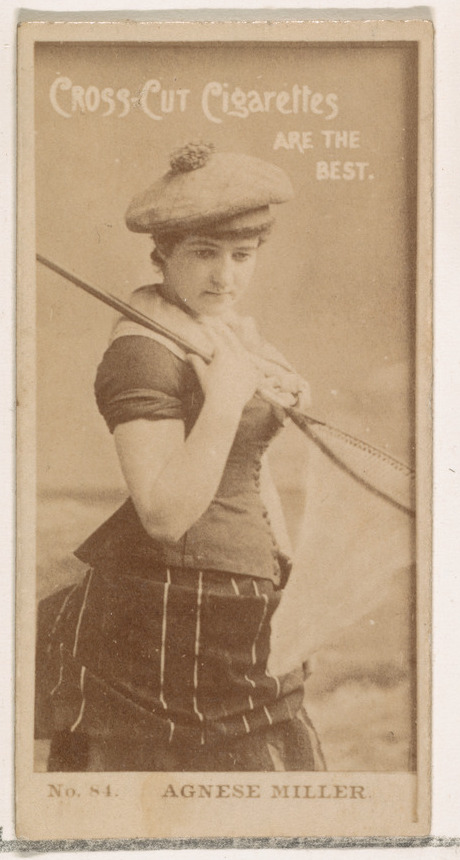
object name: print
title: Card Number 84, Agnes Miller, from the Actors and Actresses series (N145-2) issued by Duke Sons & Co. to promote Cross Cut Cigarettes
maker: w. duke, sons & co.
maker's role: publisher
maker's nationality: american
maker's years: 1870-1920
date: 1880-1889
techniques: albumen silver print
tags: portraits,women,actresses